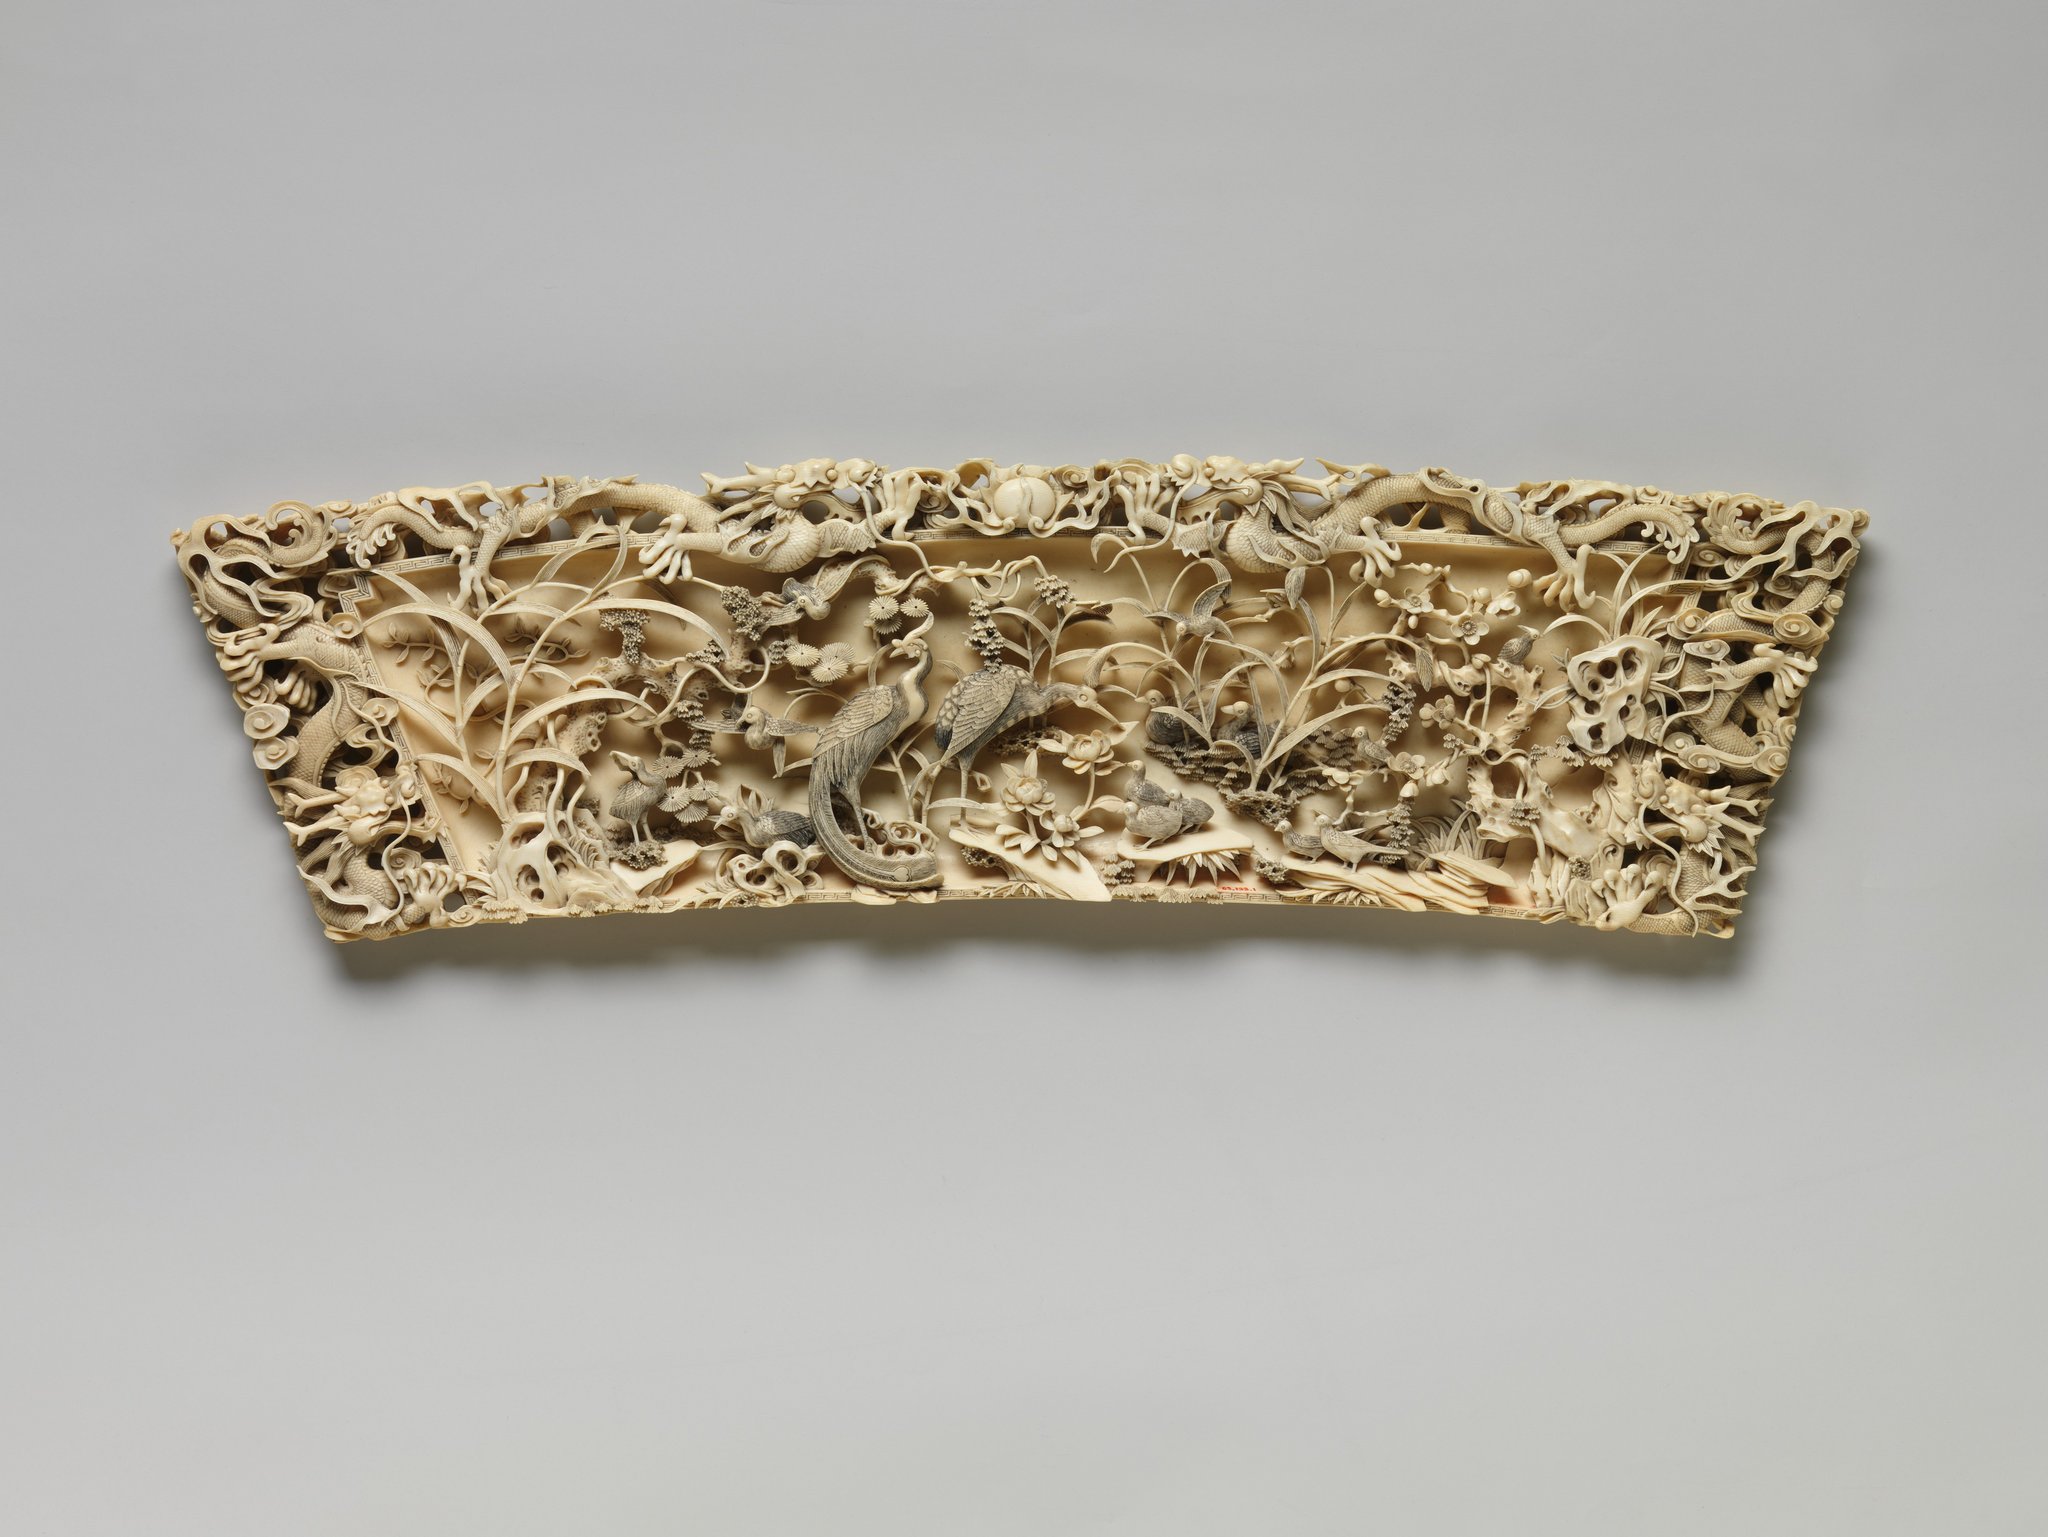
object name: plaque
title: Plaque with dragon, pheasant, quail, and other birds amidst bamboo and plum blossom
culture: chinese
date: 1867-1900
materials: ivory, pigment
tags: birds,dragons,peacocks